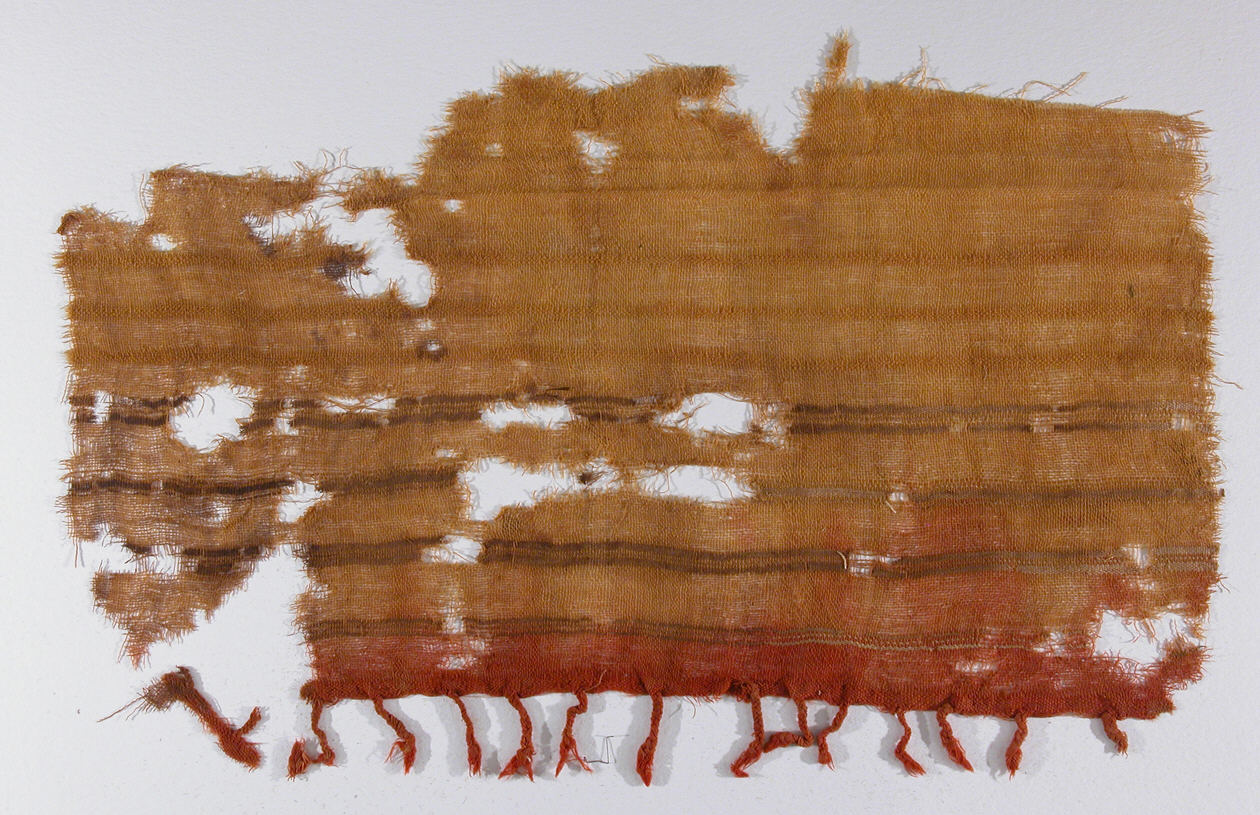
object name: textile fragment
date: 301-500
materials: linen, wool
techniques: weave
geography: egypt